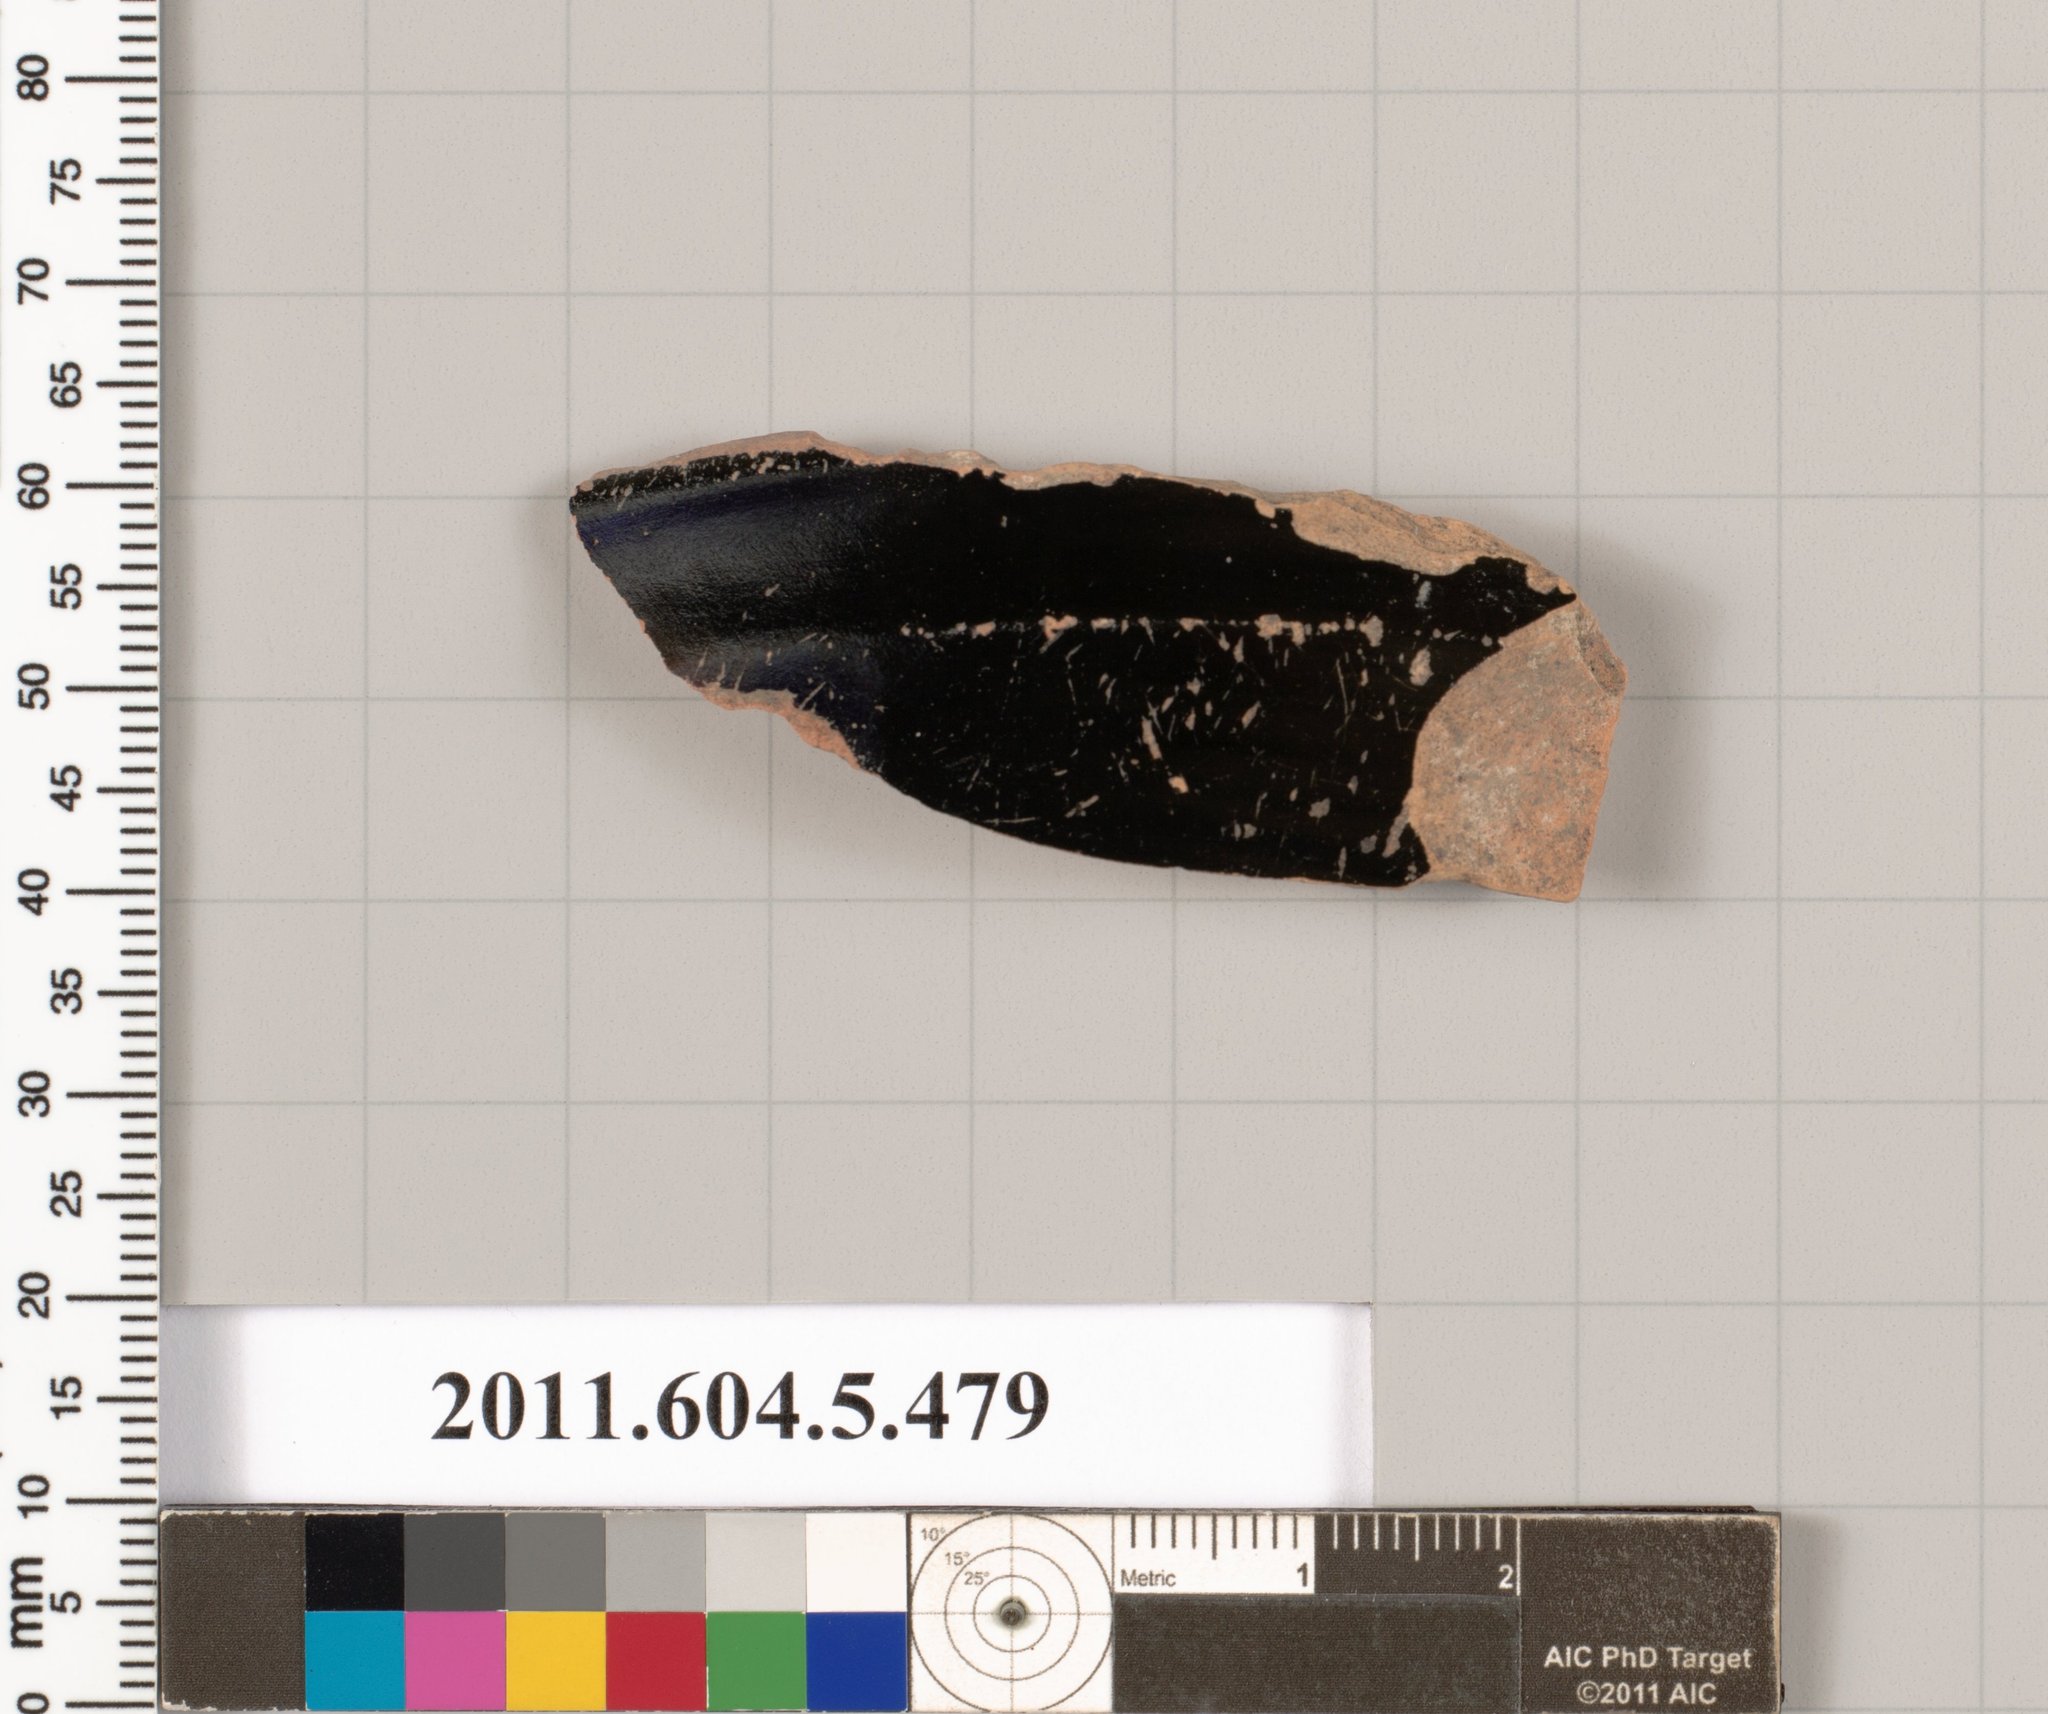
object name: kylix fragment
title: Terracotta rim fragment of a kylix (drinking cup)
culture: greek, attic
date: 600-401 BCE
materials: terracotta